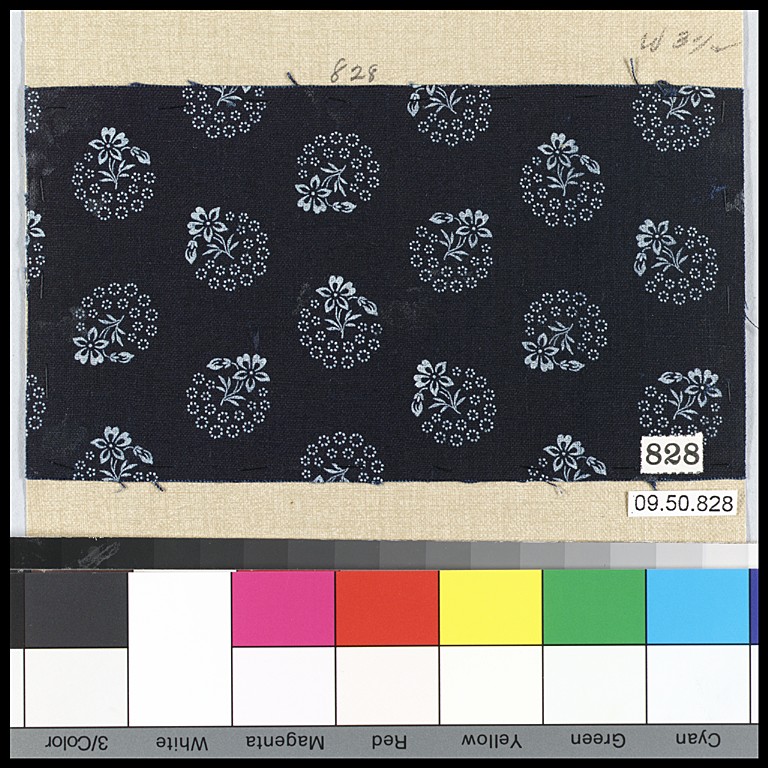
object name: piece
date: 1801-1900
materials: cotton